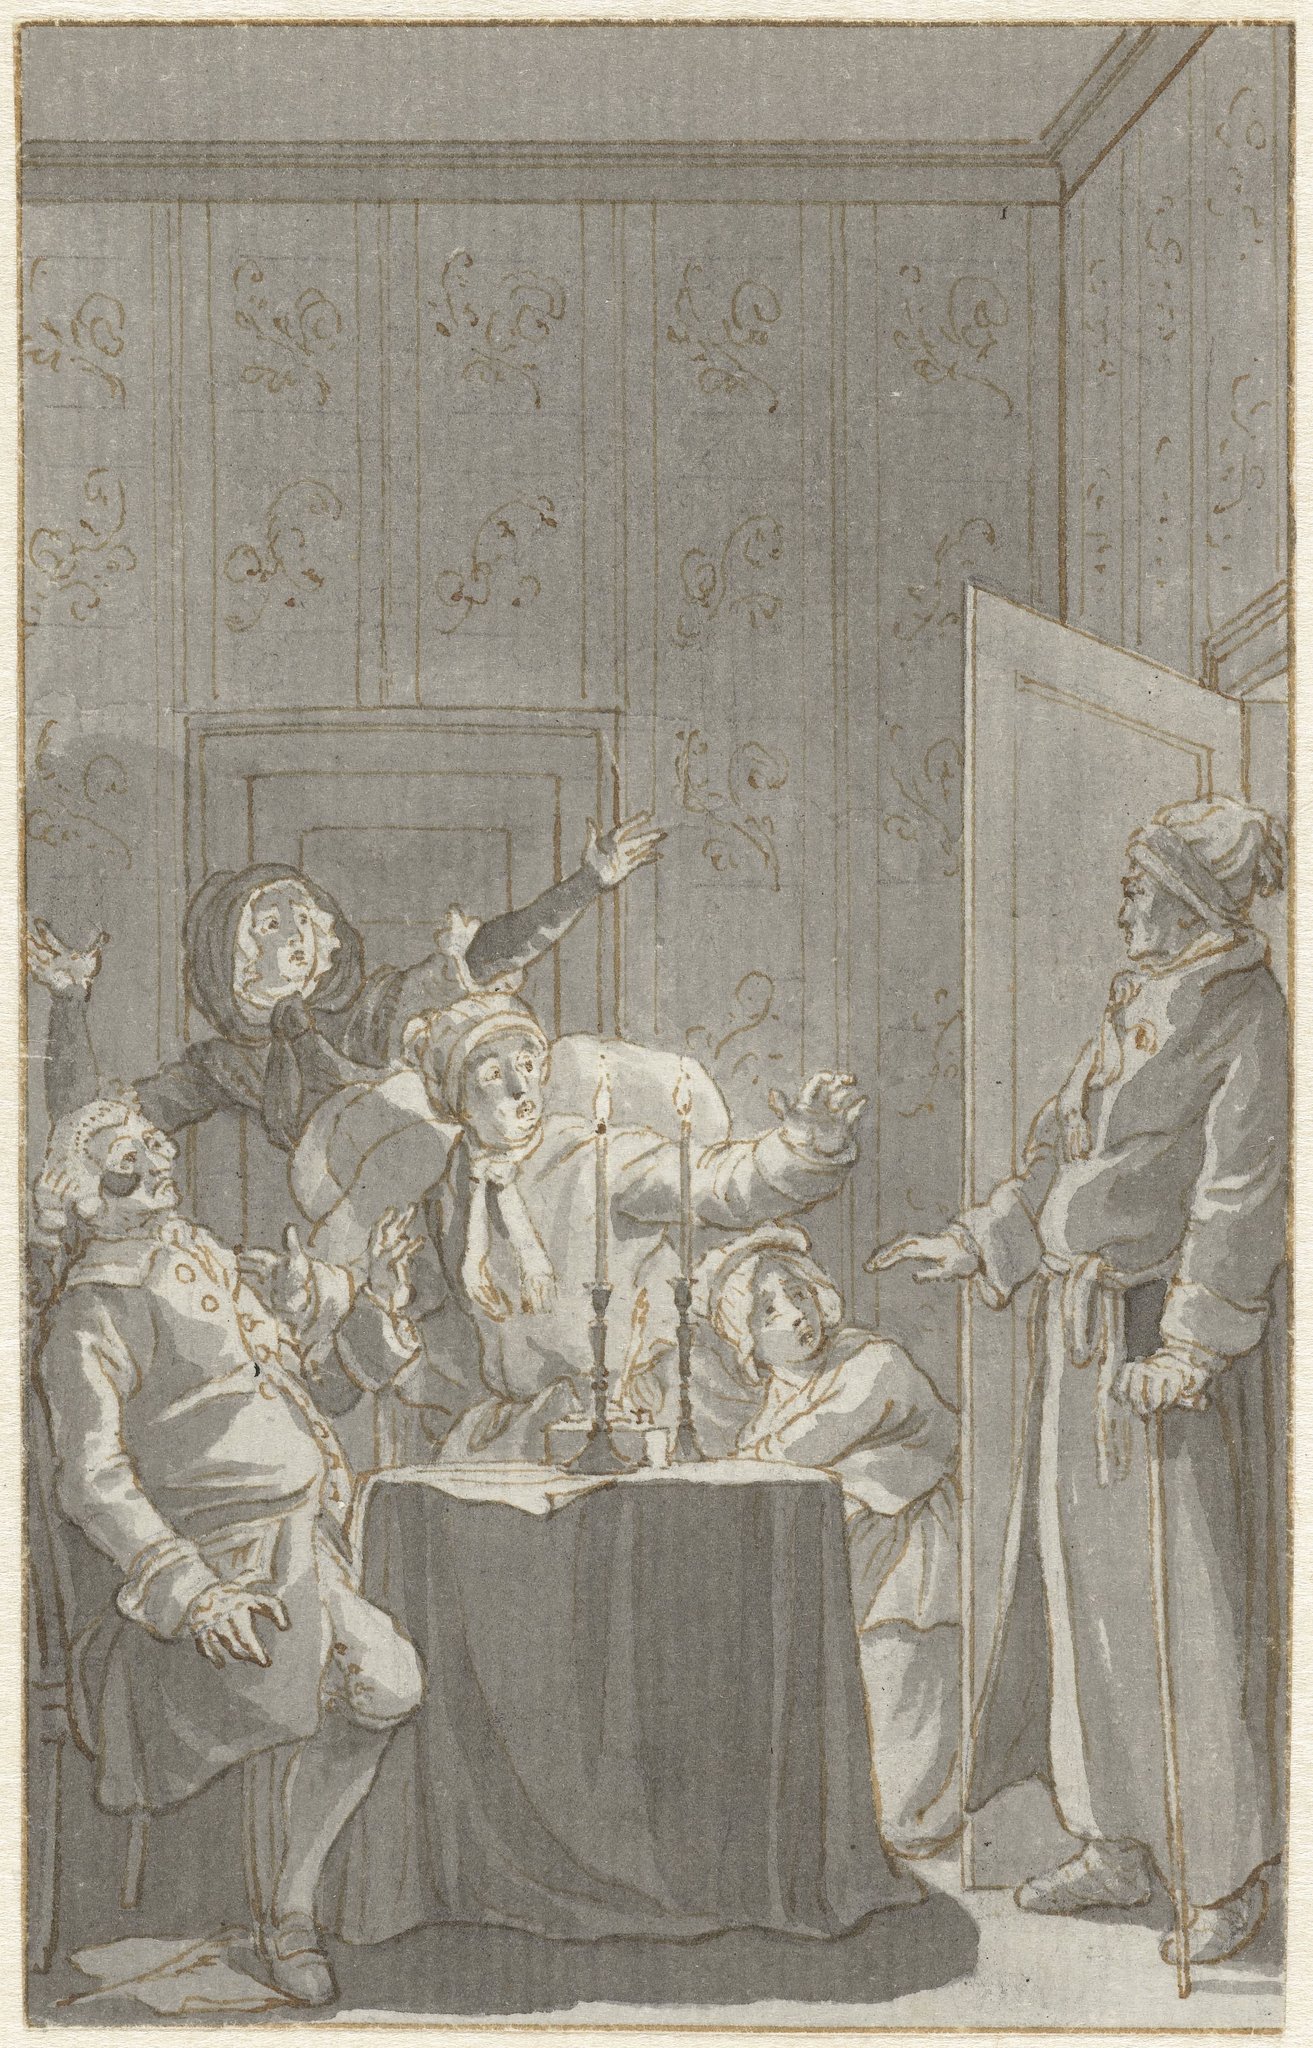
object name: drawing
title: Illustratie voor het toneelstuk Het mislukt bedrog van F.W. Gotter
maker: reinier vinkeles (i)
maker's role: draughtsman, print maker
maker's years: 1741-1816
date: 1791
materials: ink, paper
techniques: brush, pen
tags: (scenes from) specific works of literature (with author, title)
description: De doode Oom!; illustratie voor het toneelstuk `Het mislukt bedrog' van F.W. Gotter. Verschenen in Amsterdam 1791.